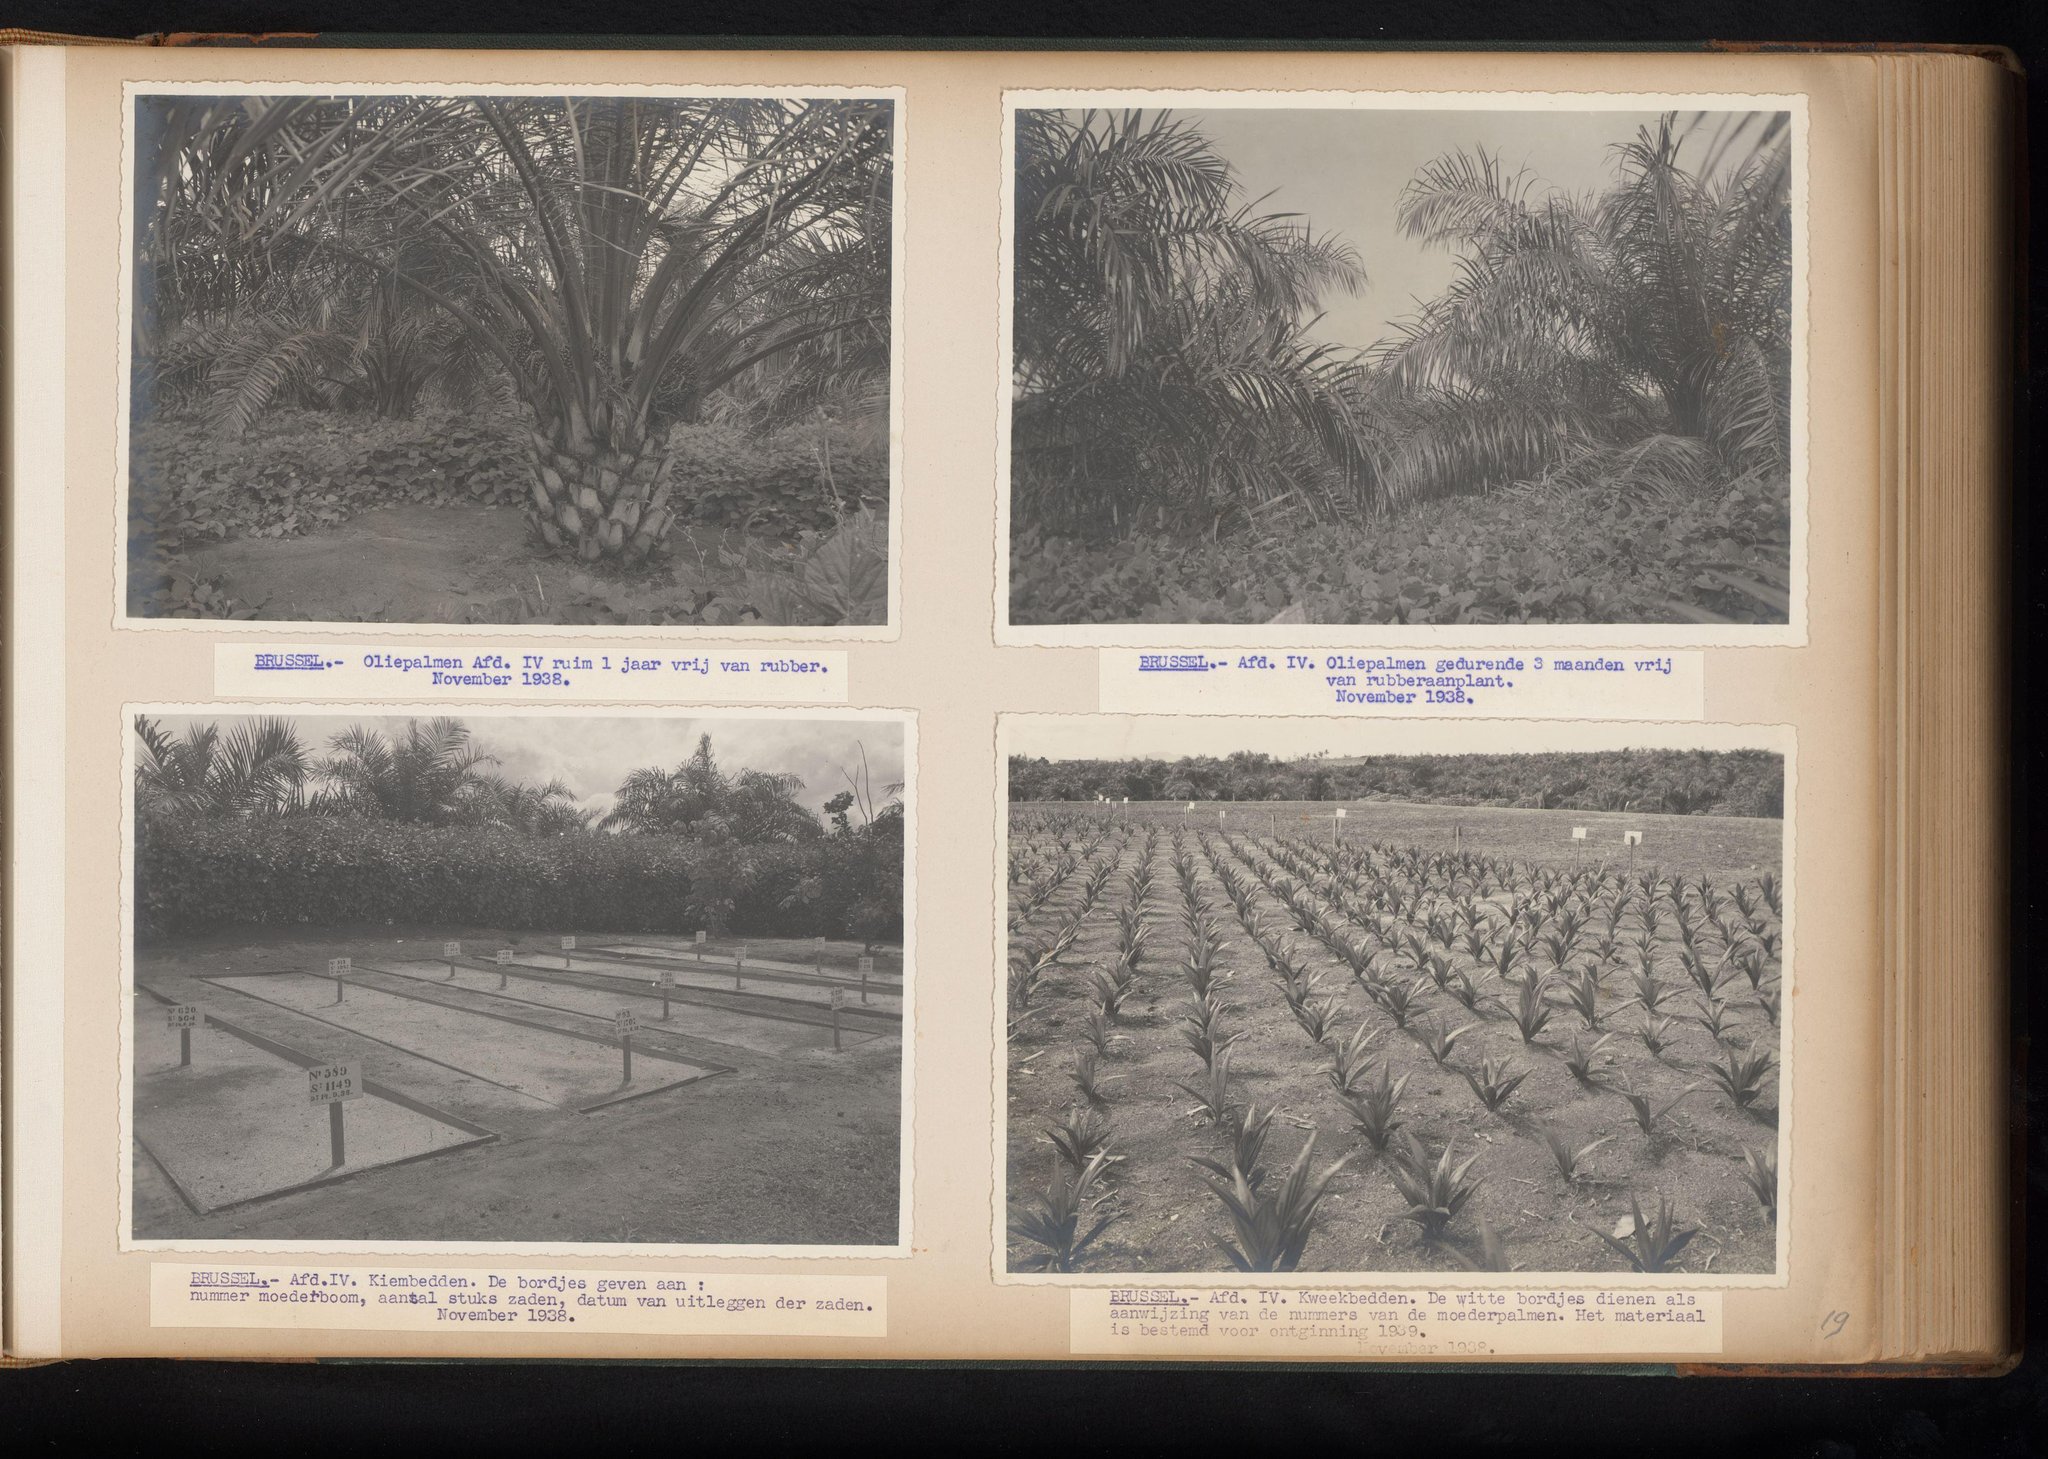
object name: photograph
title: Oliepalmen op Brussel, 1938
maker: Anonymous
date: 1911-1938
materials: cardboard, photographic support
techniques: gelatin silver print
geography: sumatra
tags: plantation, (non-fruit) products of plants or trees: palm oil, sumatra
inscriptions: inscription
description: Blad met vier foto's van de kweek van oliepalmen op Brussel, 1938. Met etiketten met onderschriften onder de foto's. Onderdeel van het fotoalbum over de plantages Pernantian en Brussel van de Sumatra Caoutchouc Maatschappij op de Oostkust van Sumatra in de jaren 1935-1939.